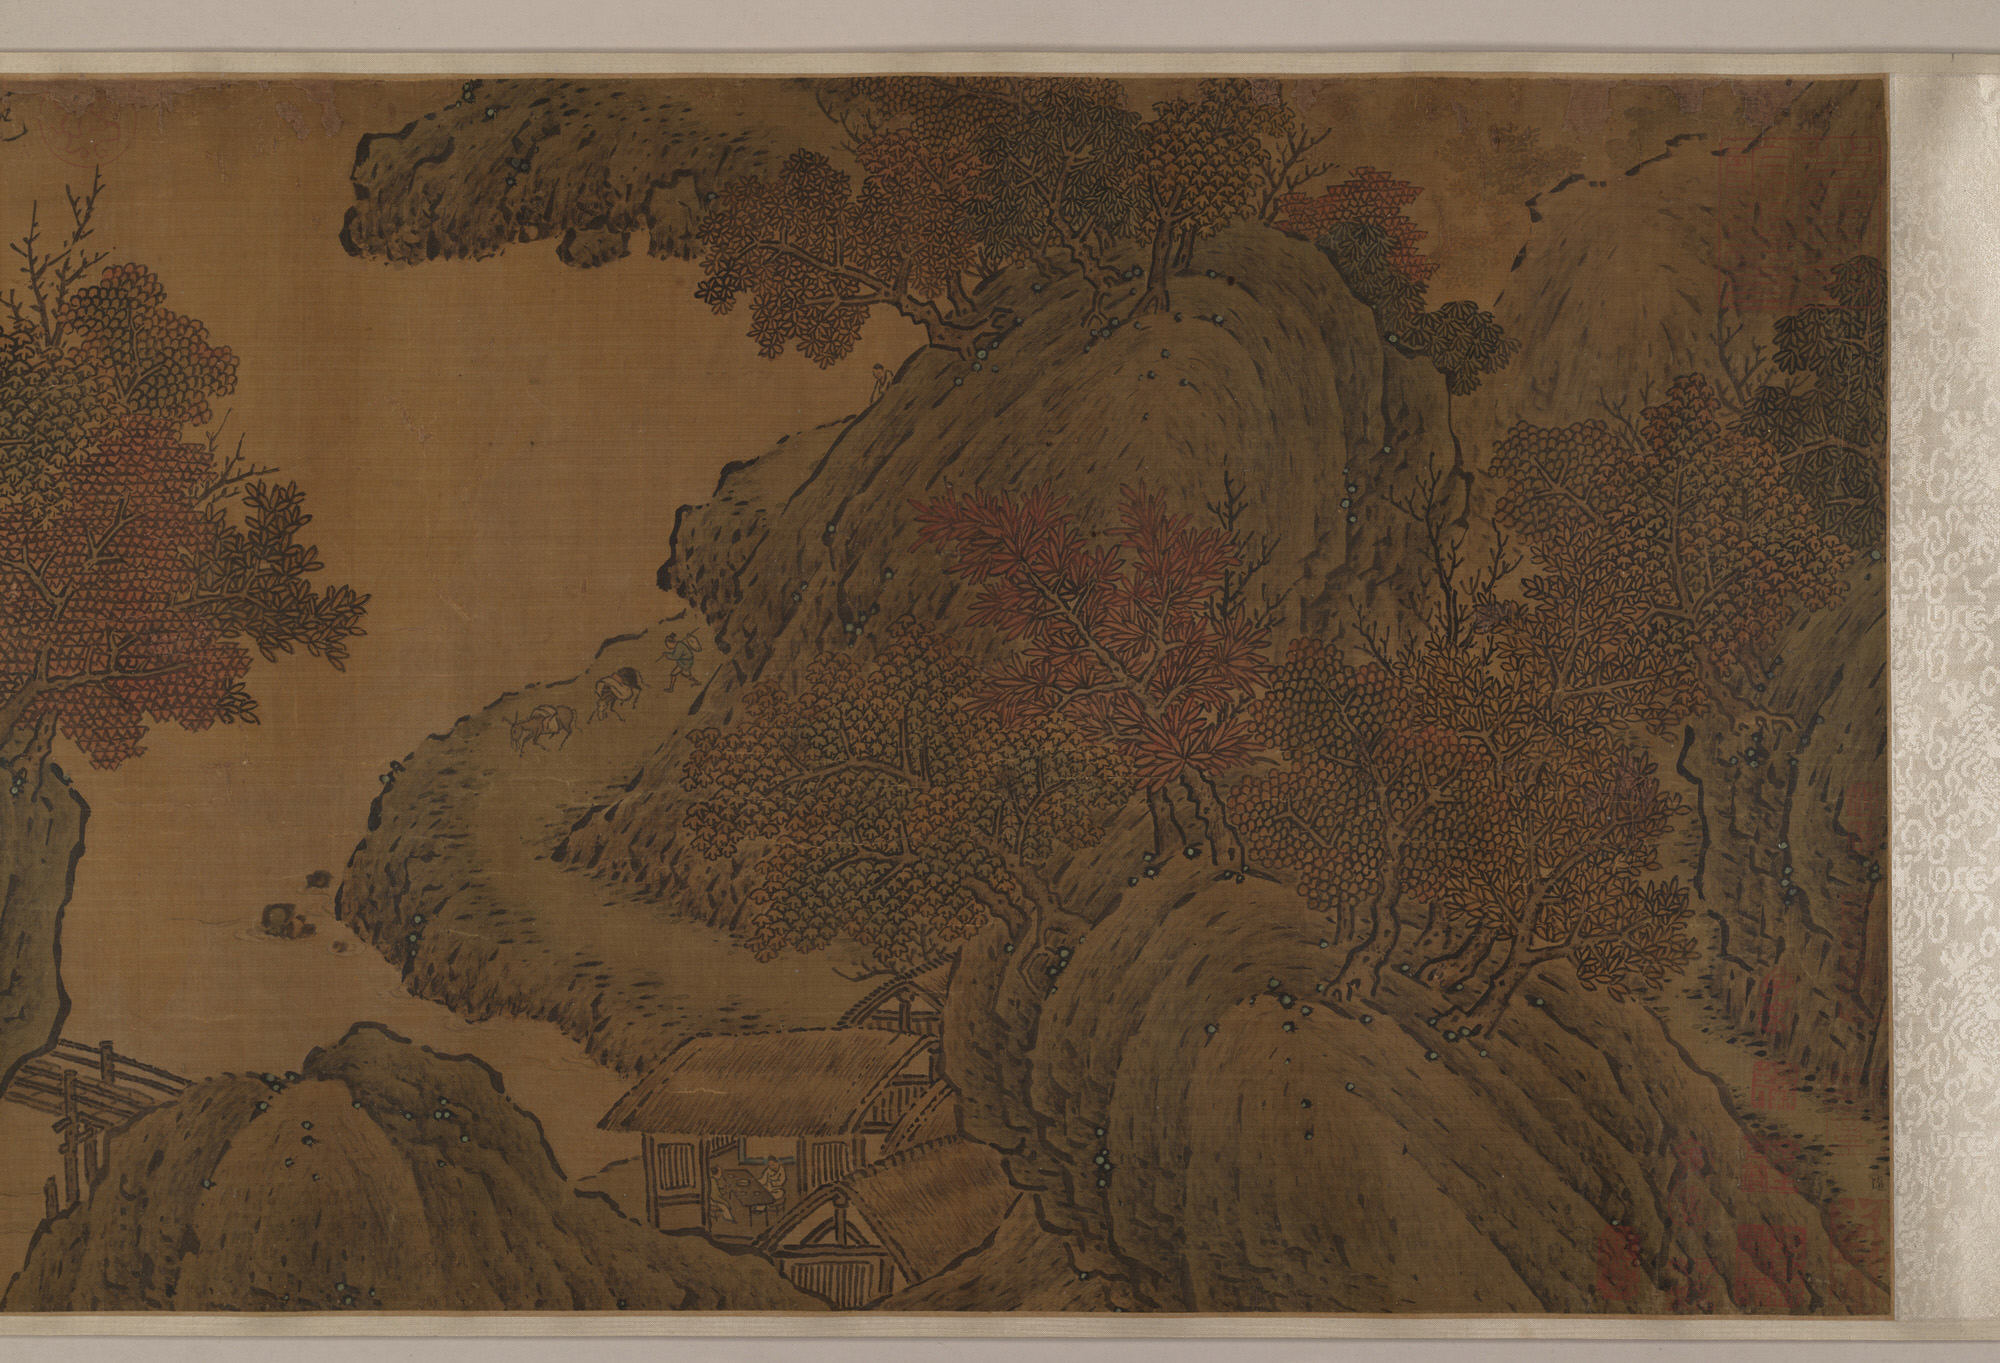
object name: handscroll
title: Autumn Landscape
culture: chinese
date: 1368-1911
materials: ink, silk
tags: landscapes